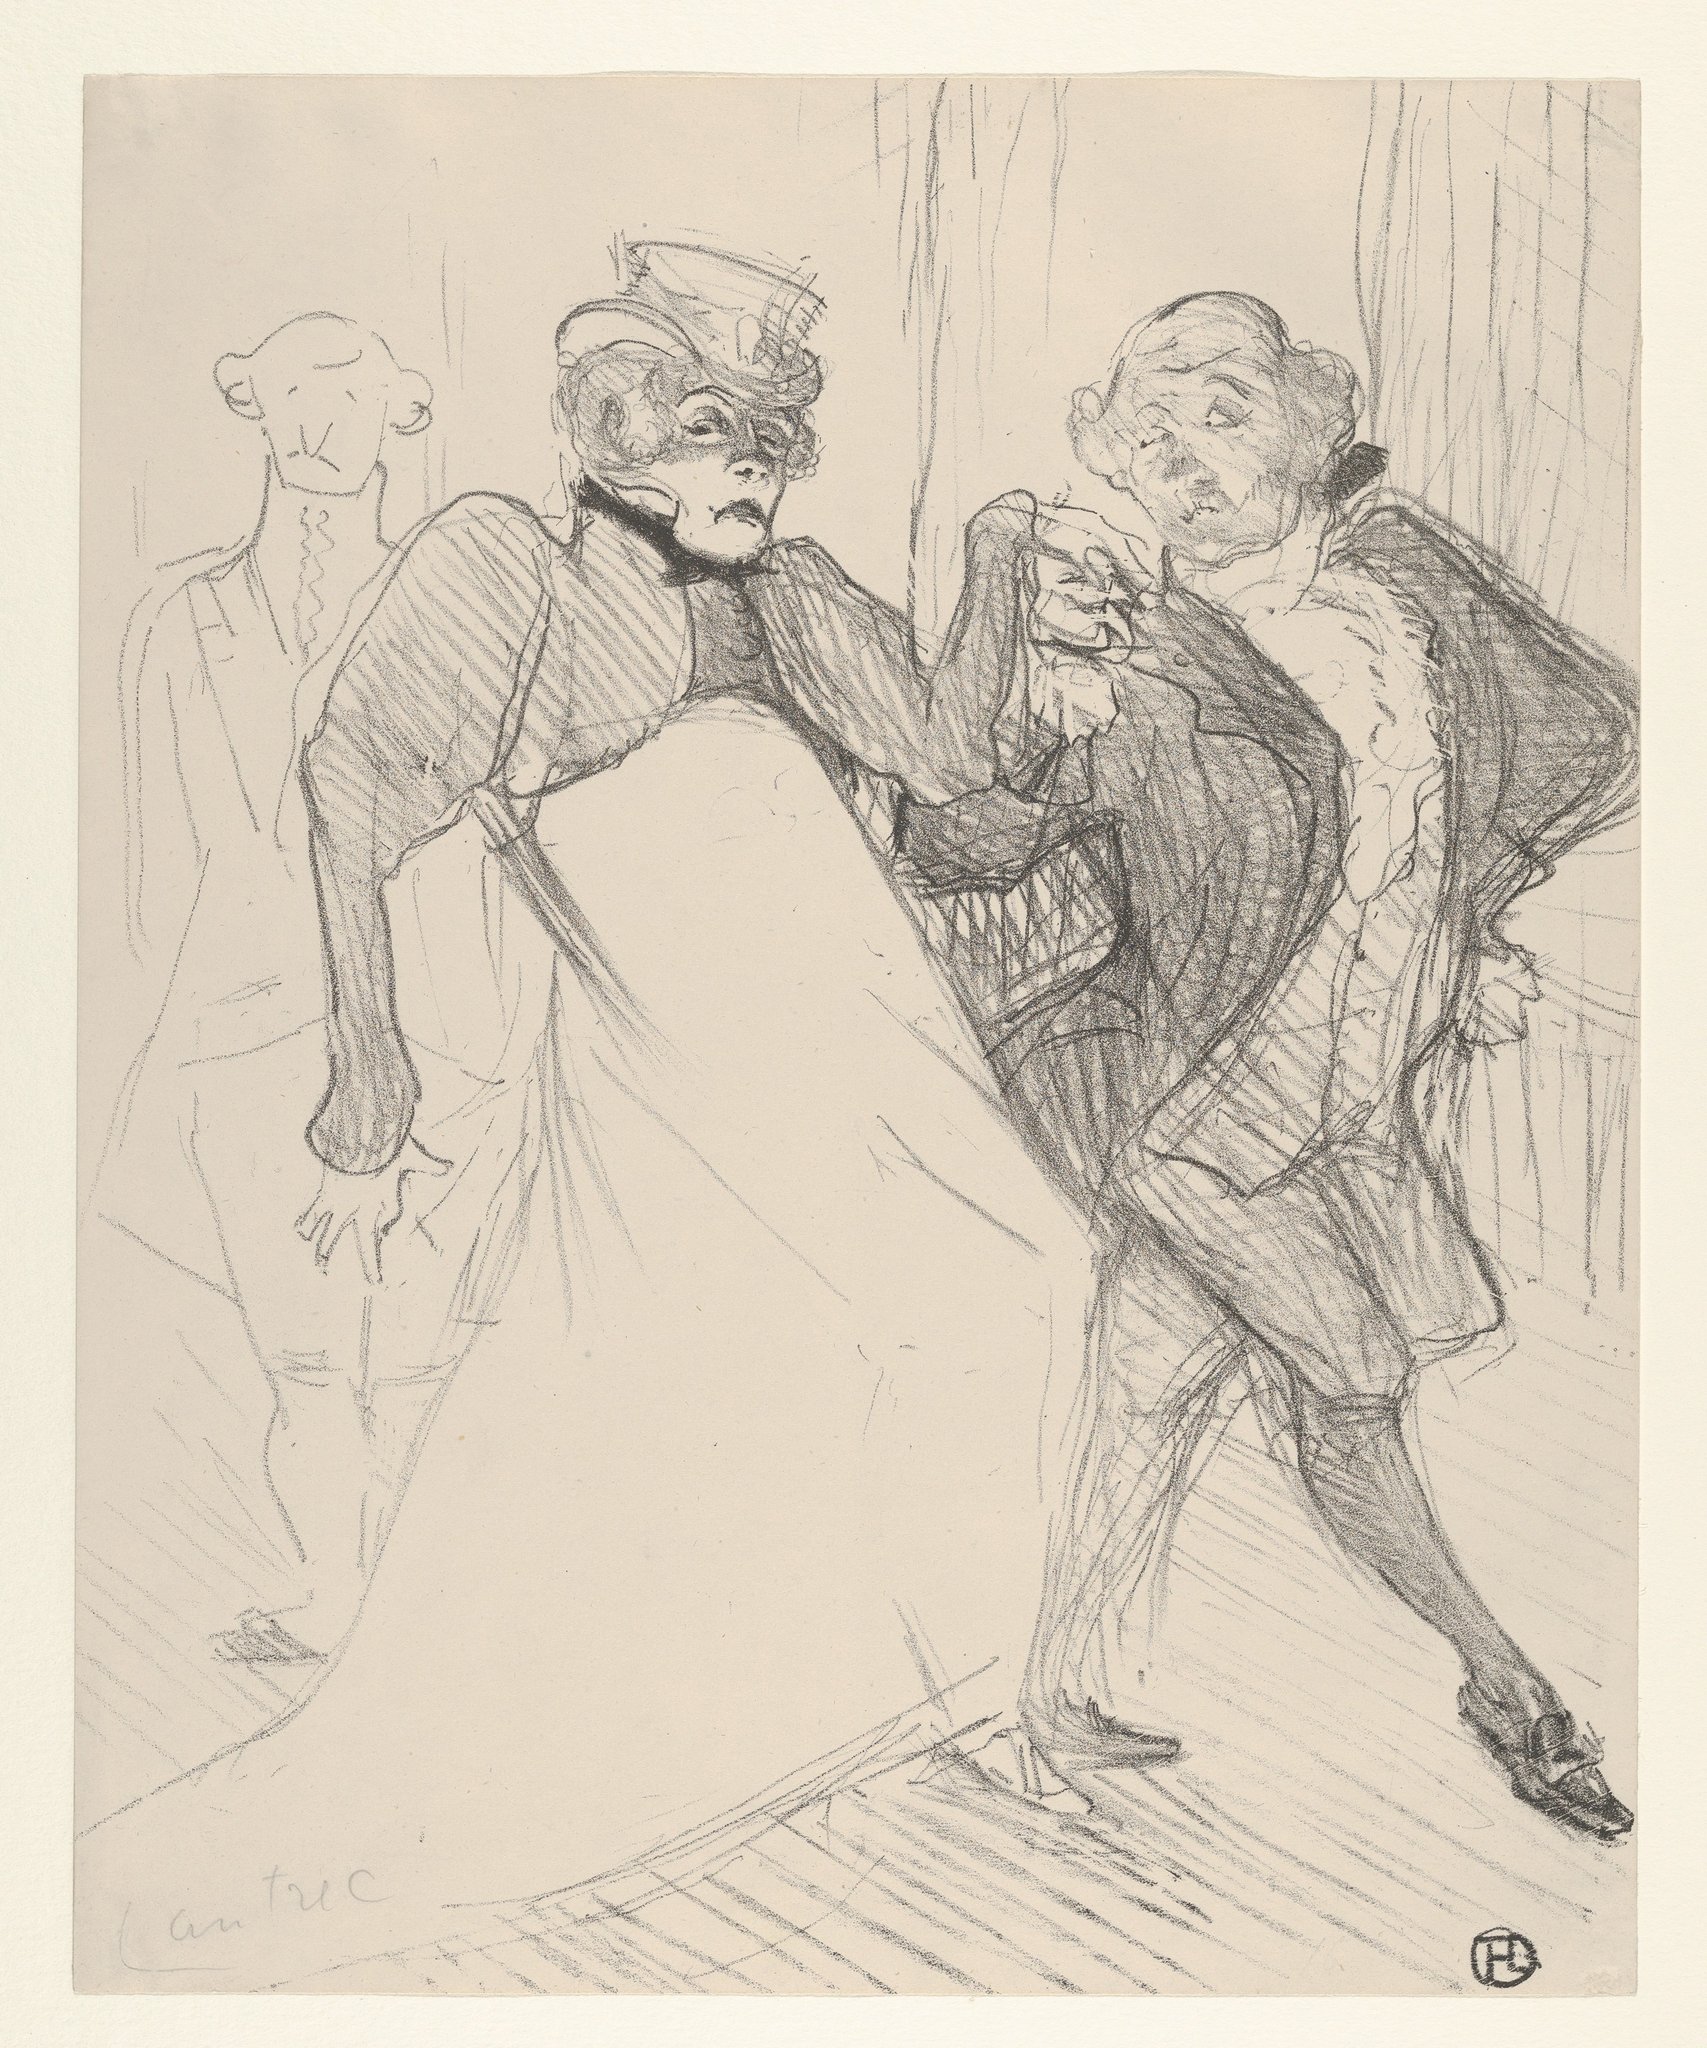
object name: print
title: Réjane and Galipaux, in Madame Sans-Géne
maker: henri de toulouse-lautrec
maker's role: artist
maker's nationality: french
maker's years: 1864-1901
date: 1893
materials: crayon, ink, paper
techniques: lithograph, printing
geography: france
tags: men,women